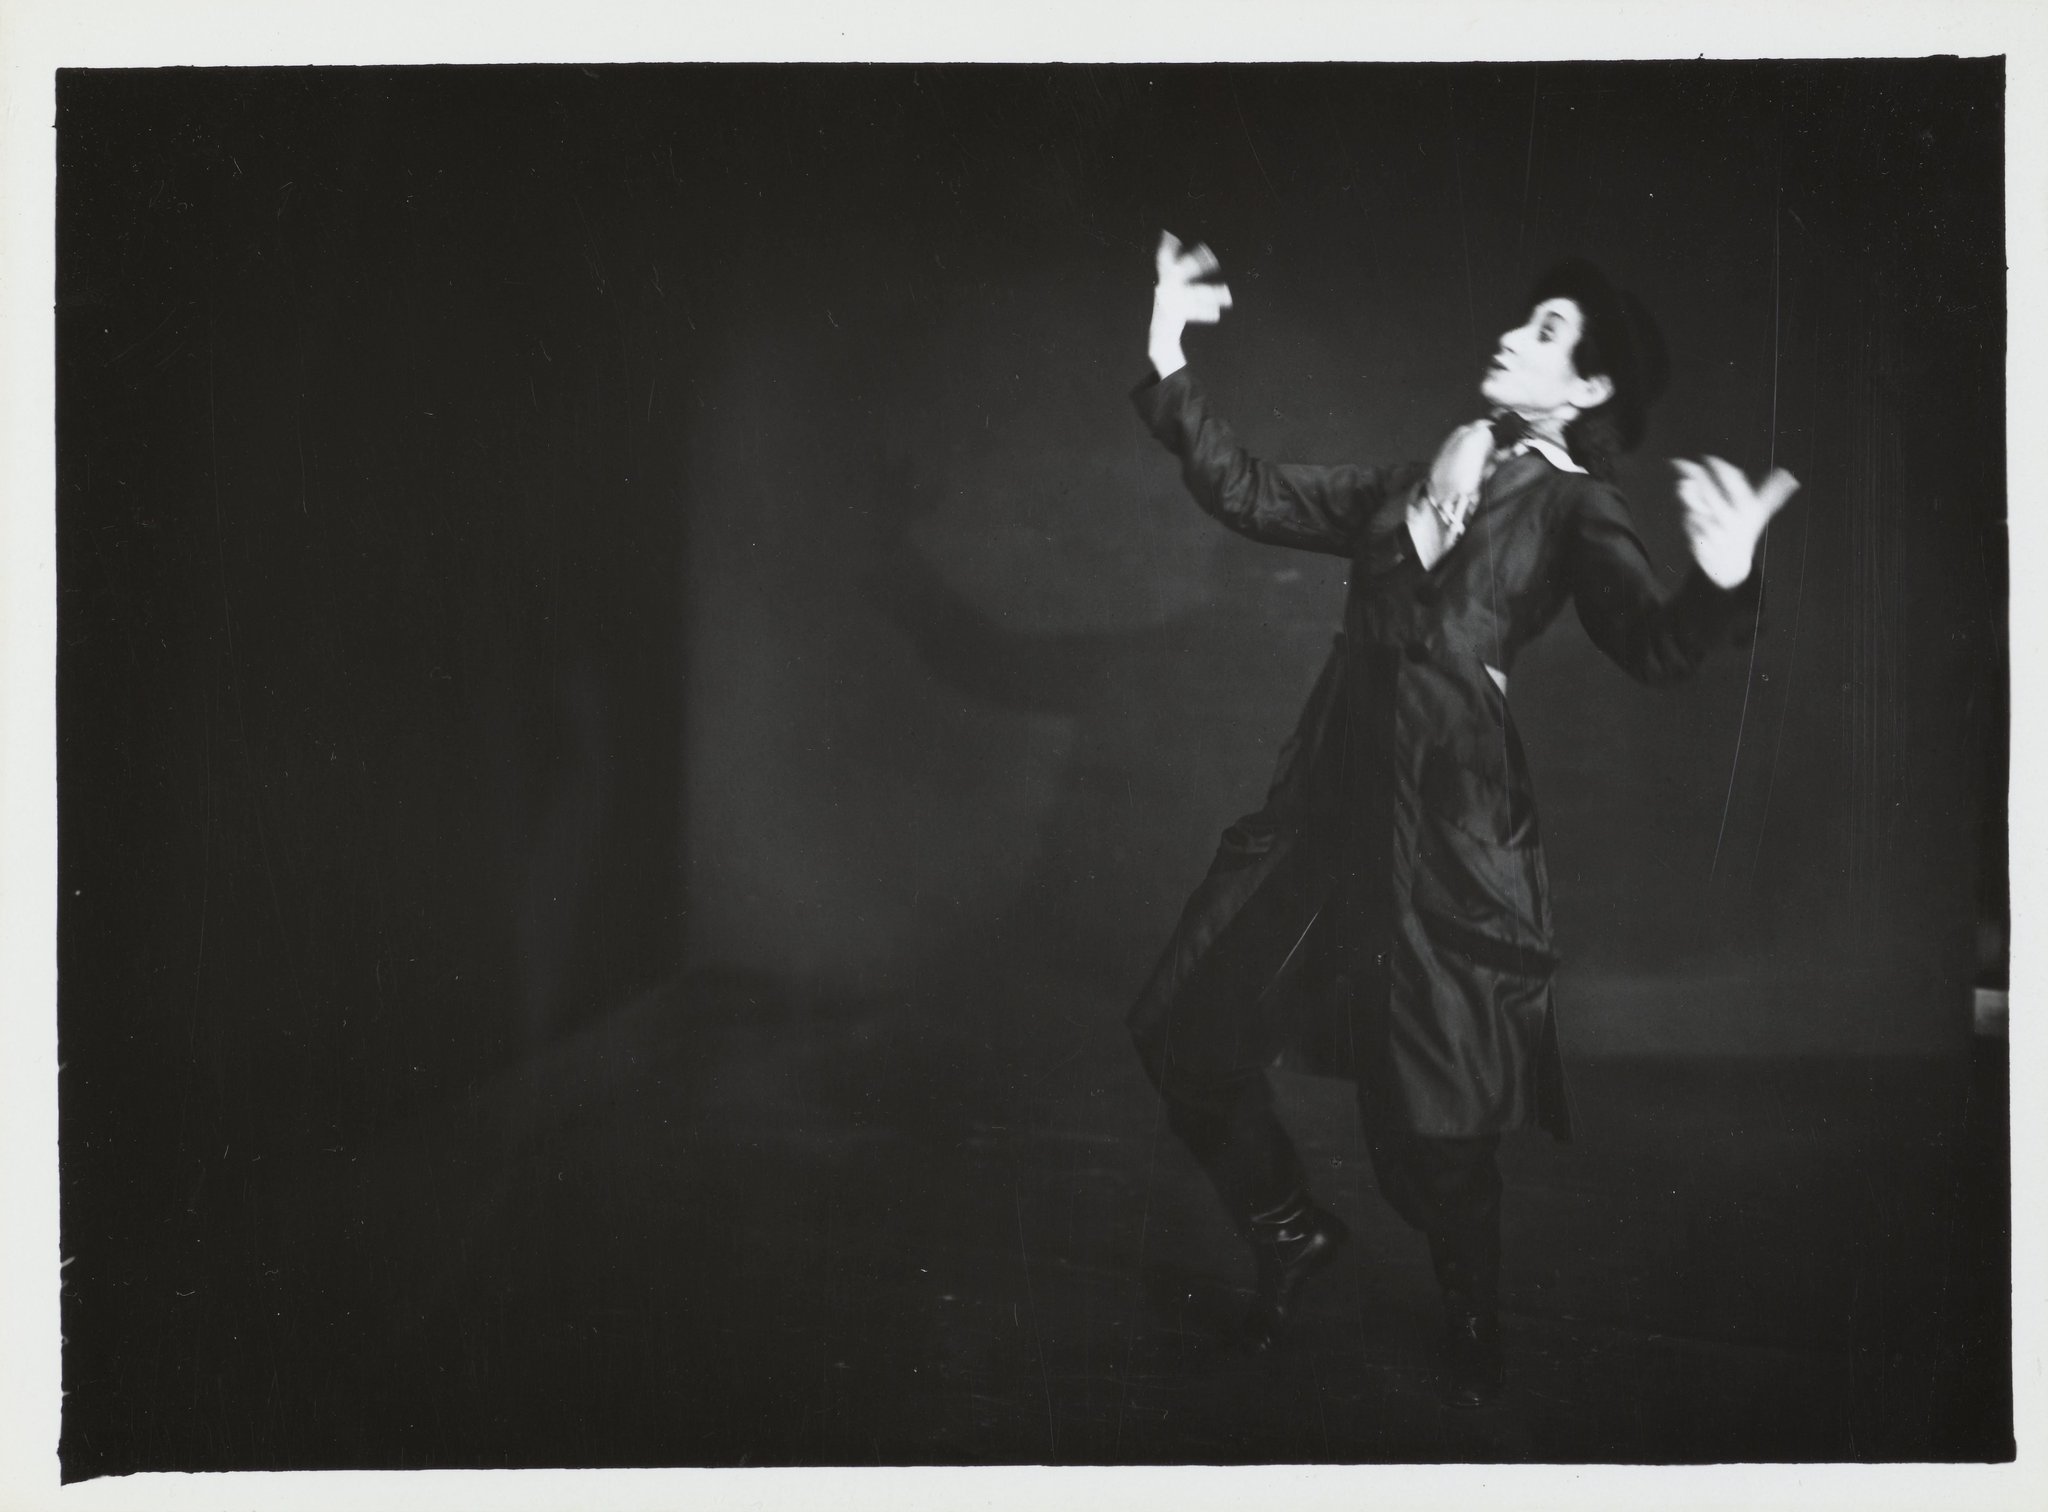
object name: photograph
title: Chaja Goldstein tijdens toneelspel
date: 1930-1942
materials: paper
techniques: gelatin silver print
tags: historical persons - bb - woman, female dancer